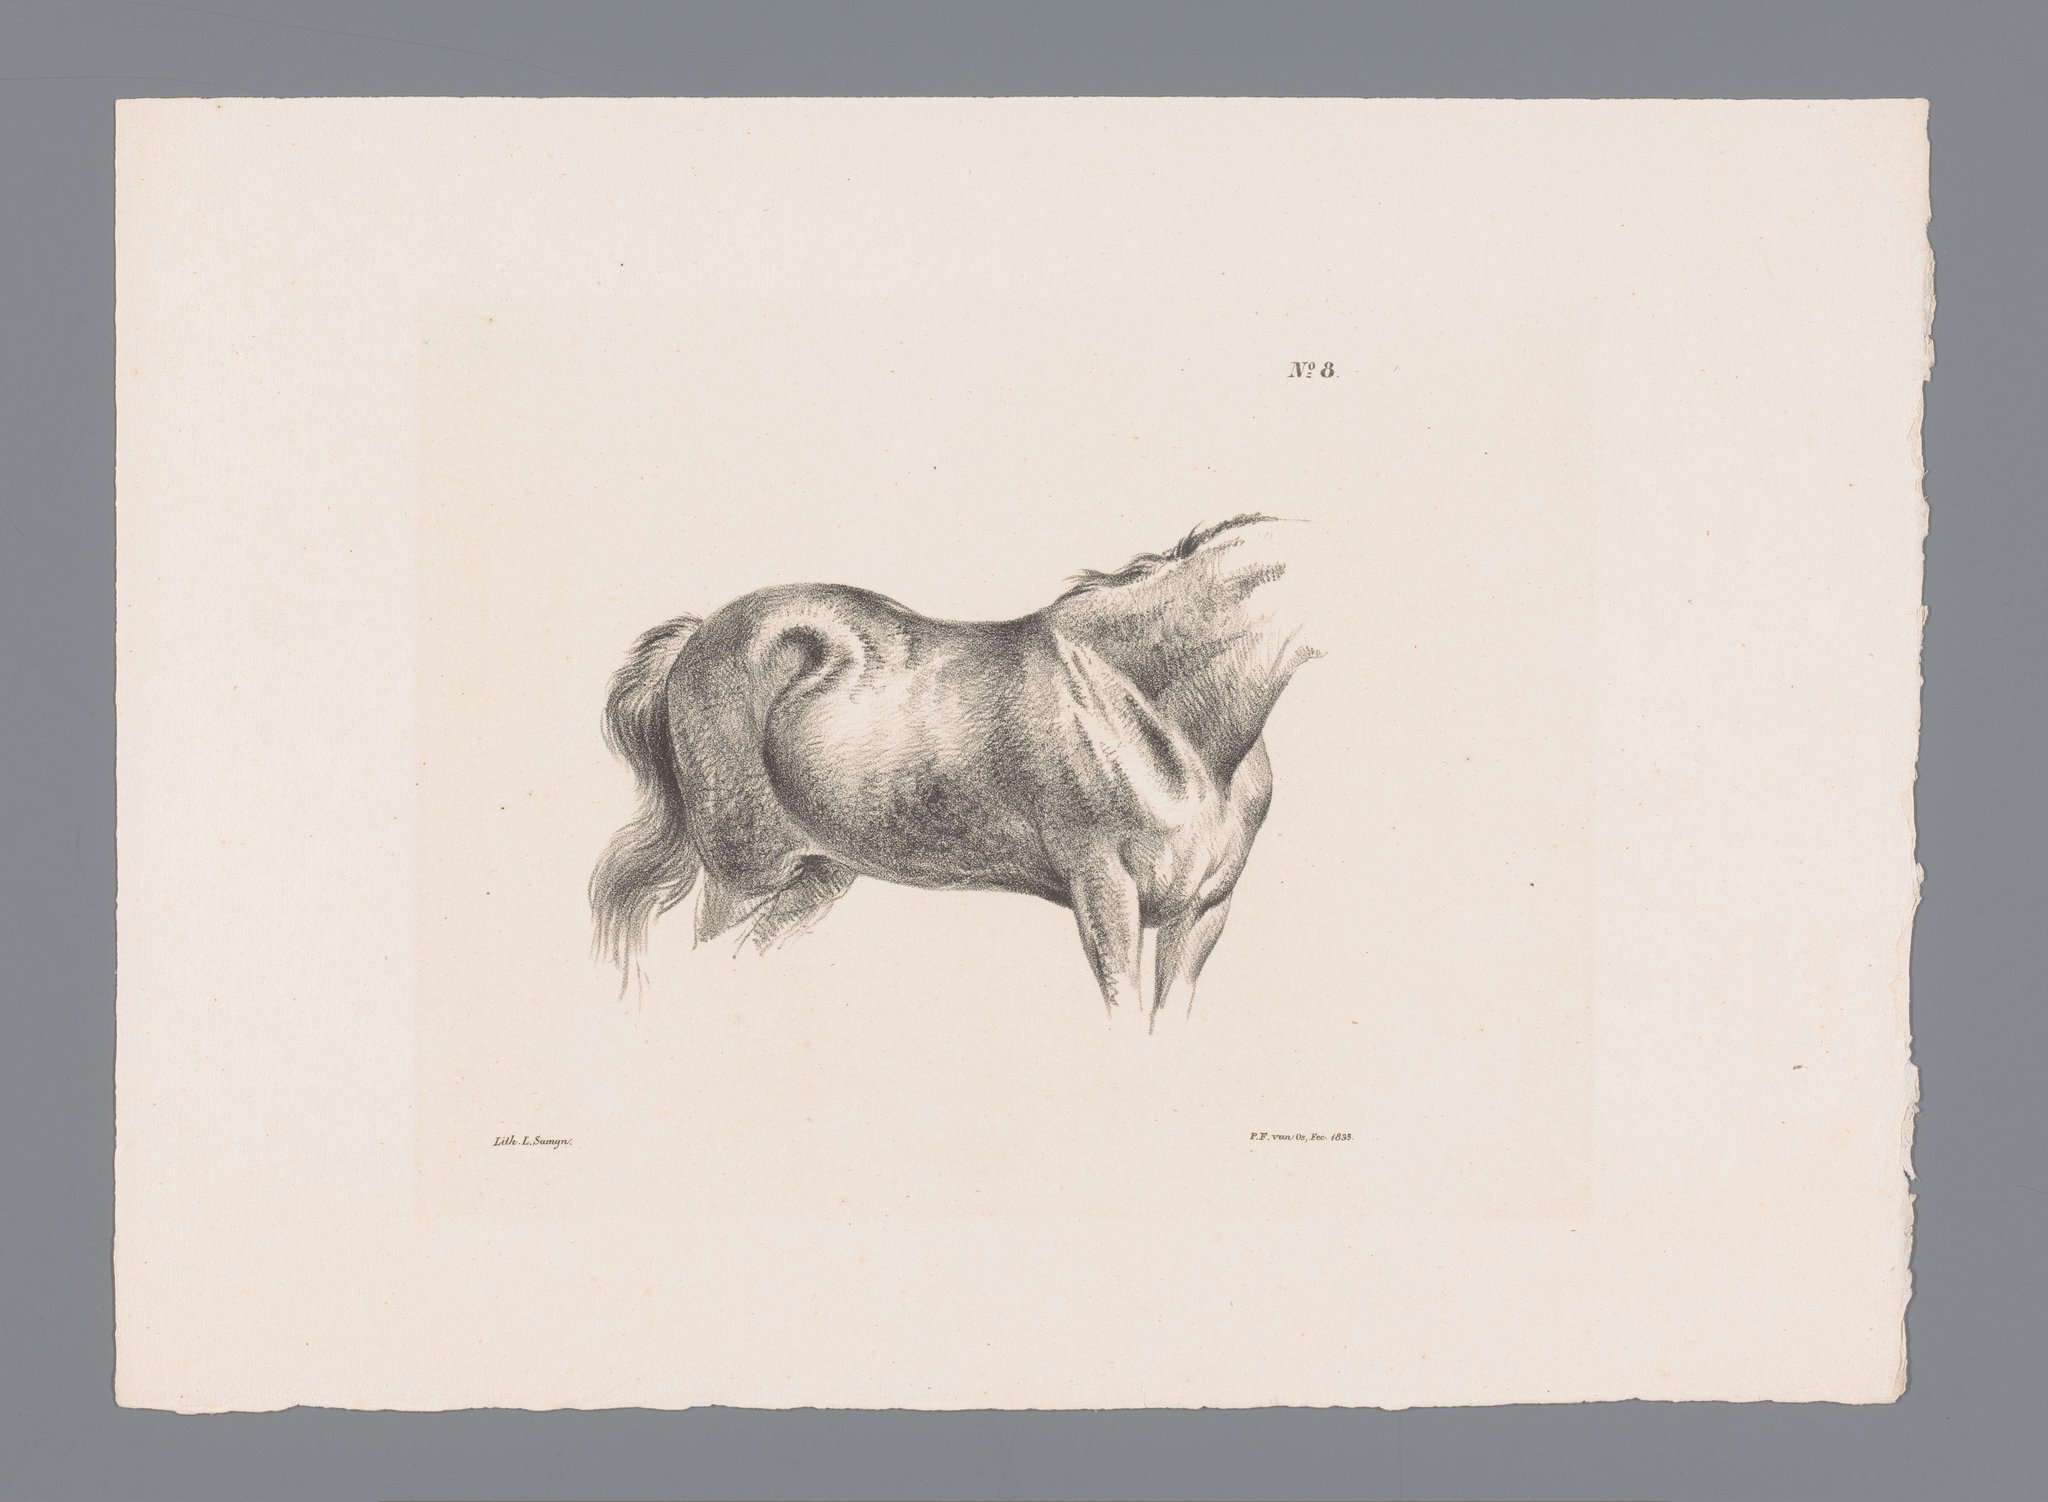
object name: print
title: Paardenromp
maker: l. samijn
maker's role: printer, publisher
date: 1835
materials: paper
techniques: lithograph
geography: amsterdam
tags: animals (+ head of an animal), horse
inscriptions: collector's mark: Lugt 2228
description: Onderdeel van een omslag met een serie van tien paardenstudies.